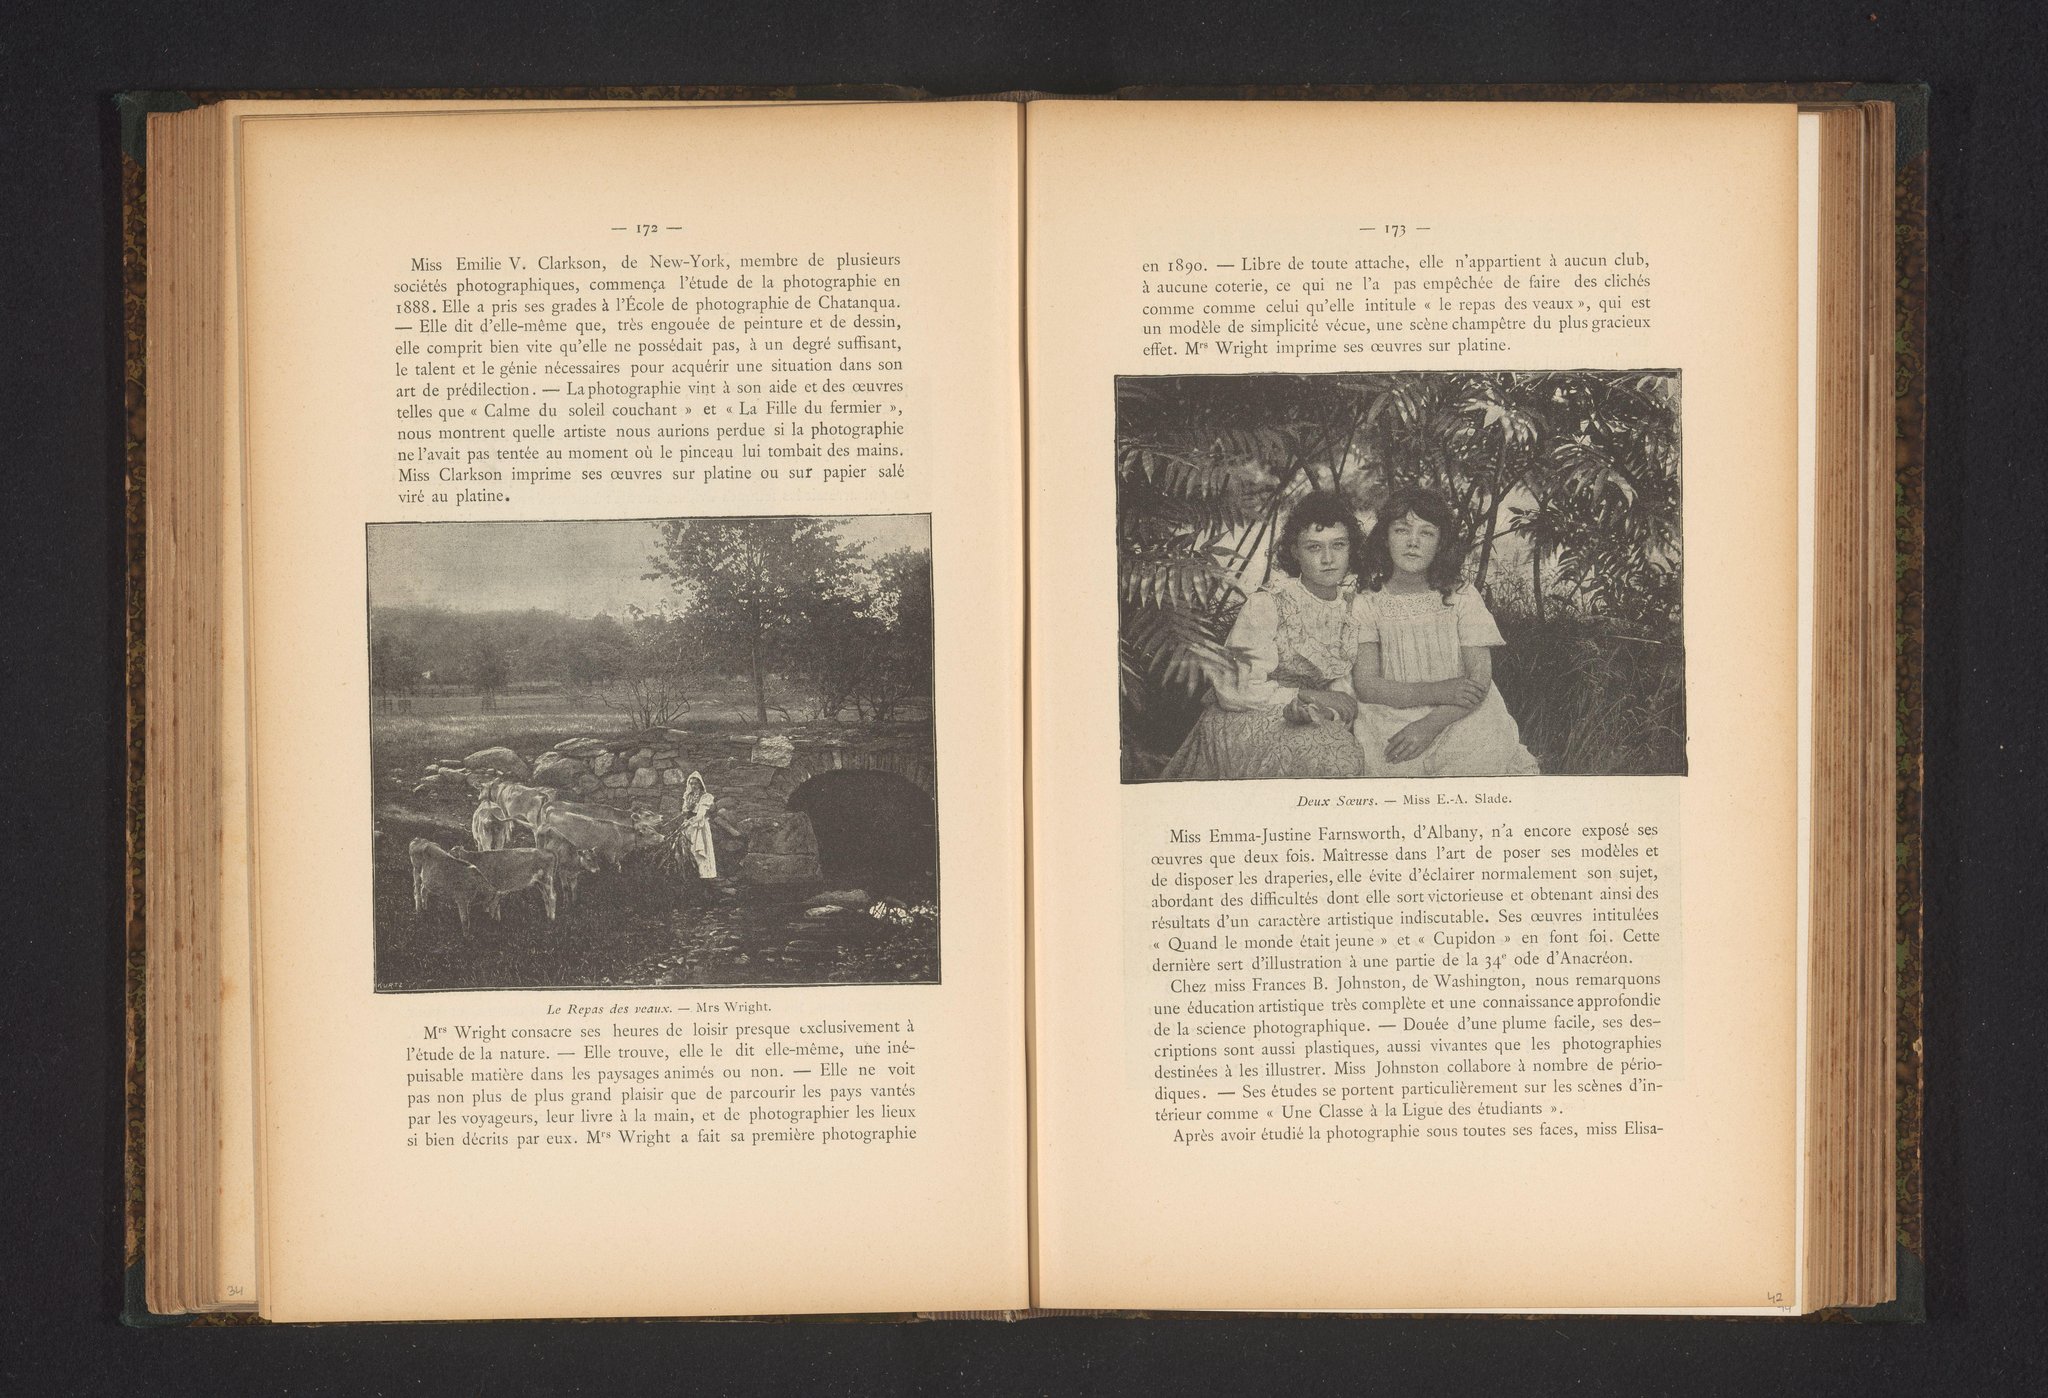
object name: page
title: Deux Soeurs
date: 1890-1895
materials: paper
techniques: autotype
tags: historical persons not known by name - bb - woman